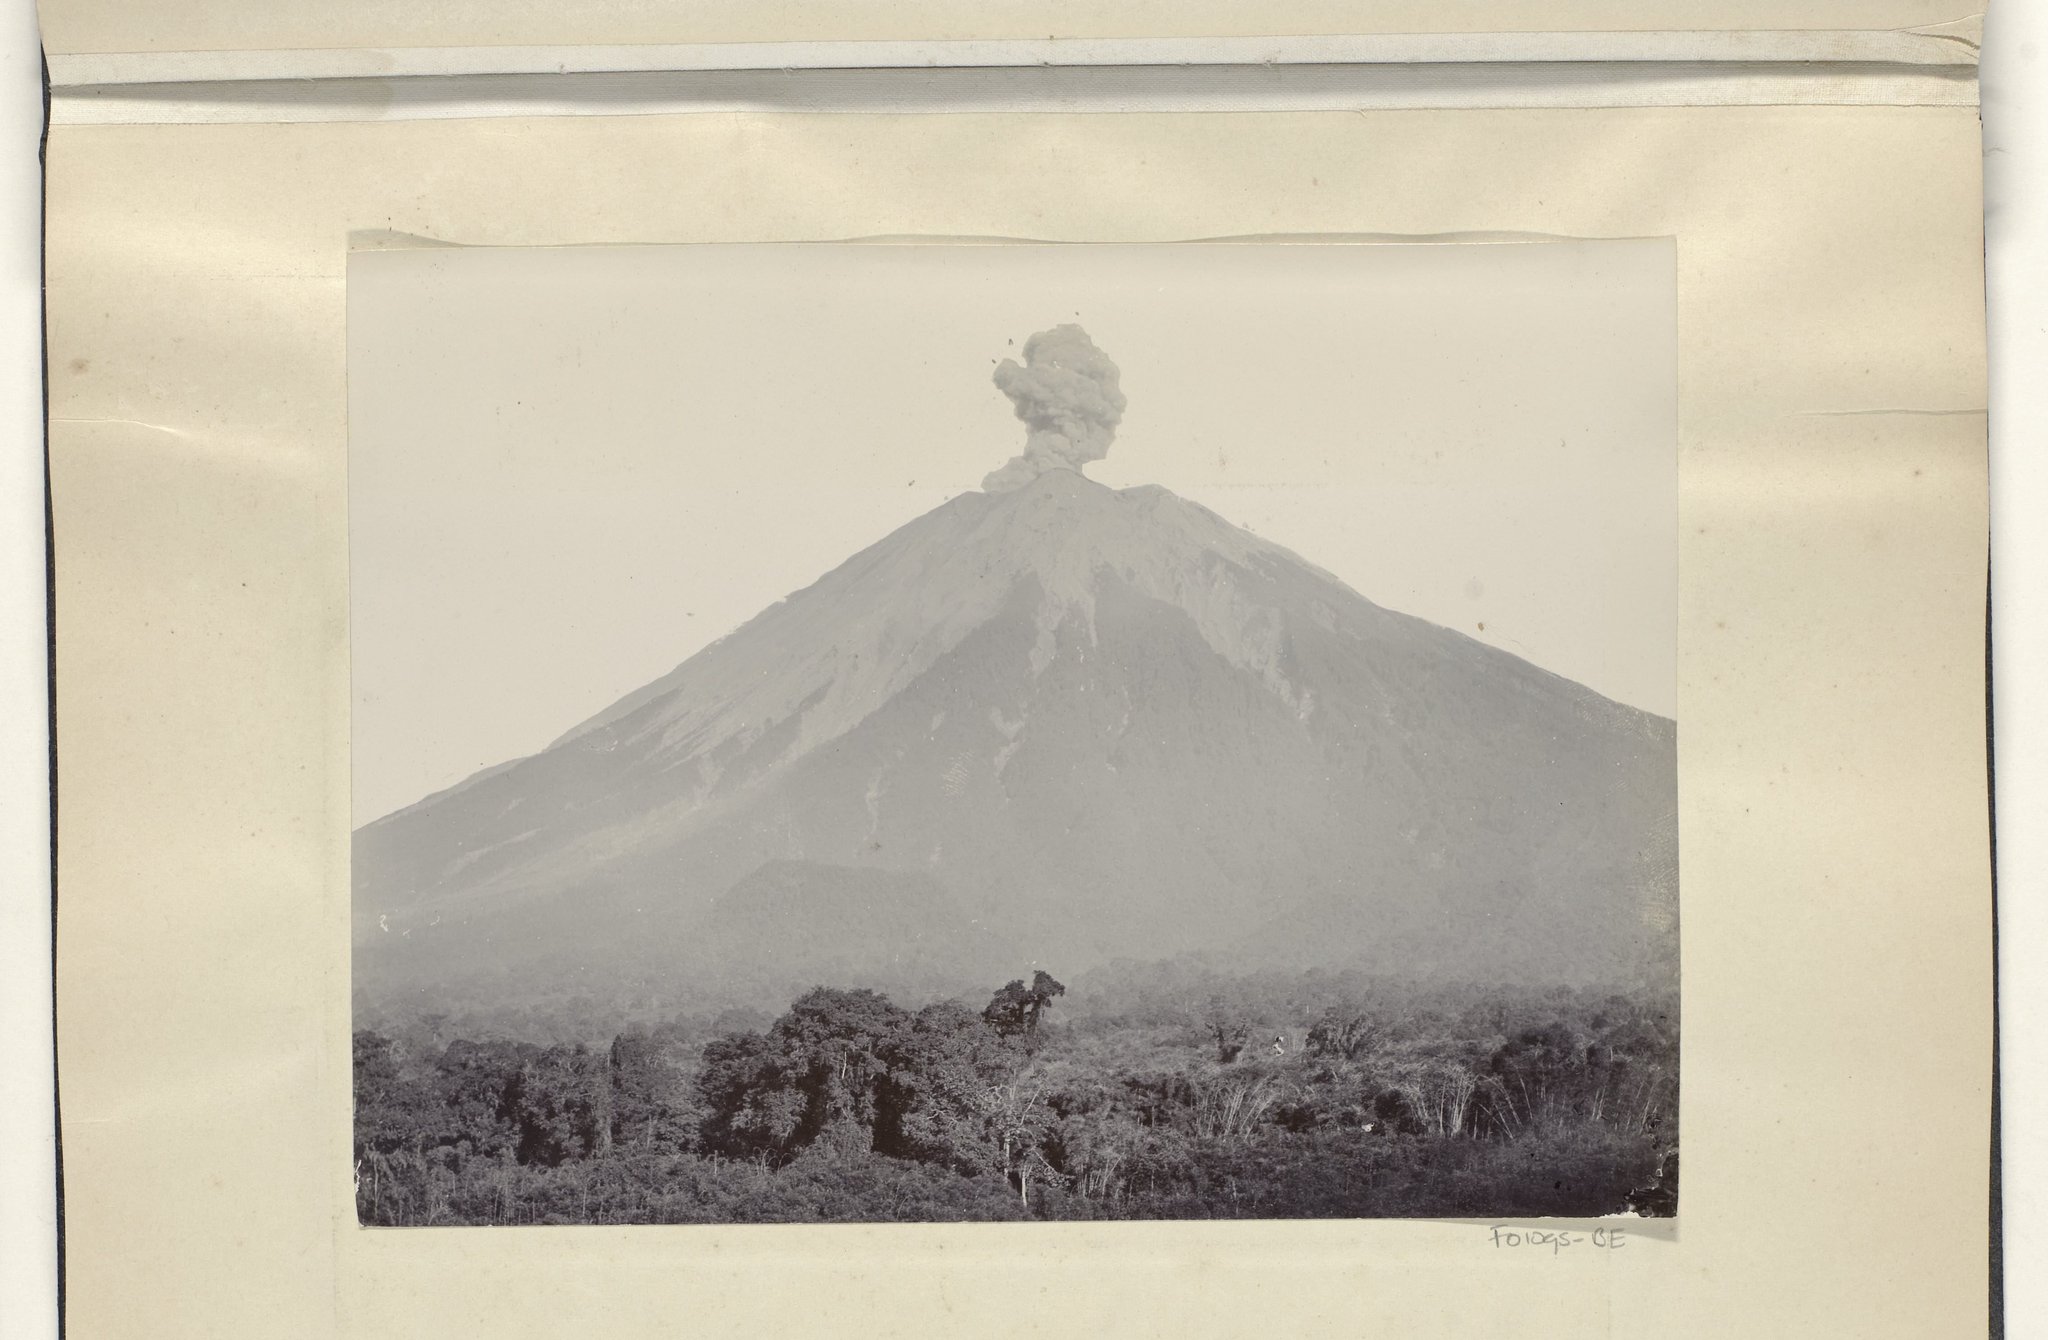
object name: photograph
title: Rokende vulkaan in Nederlands-Indië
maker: Anonymous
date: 1895-1905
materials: paper, photographic support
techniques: gelatin silver print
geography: dutch east indies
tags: eruption (of volcano), dutch east indies, the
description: Onderdeel van Reisalbum met foto's van bezienswaardigheden in Italië, Zwitserland en Nederlands-Indië.